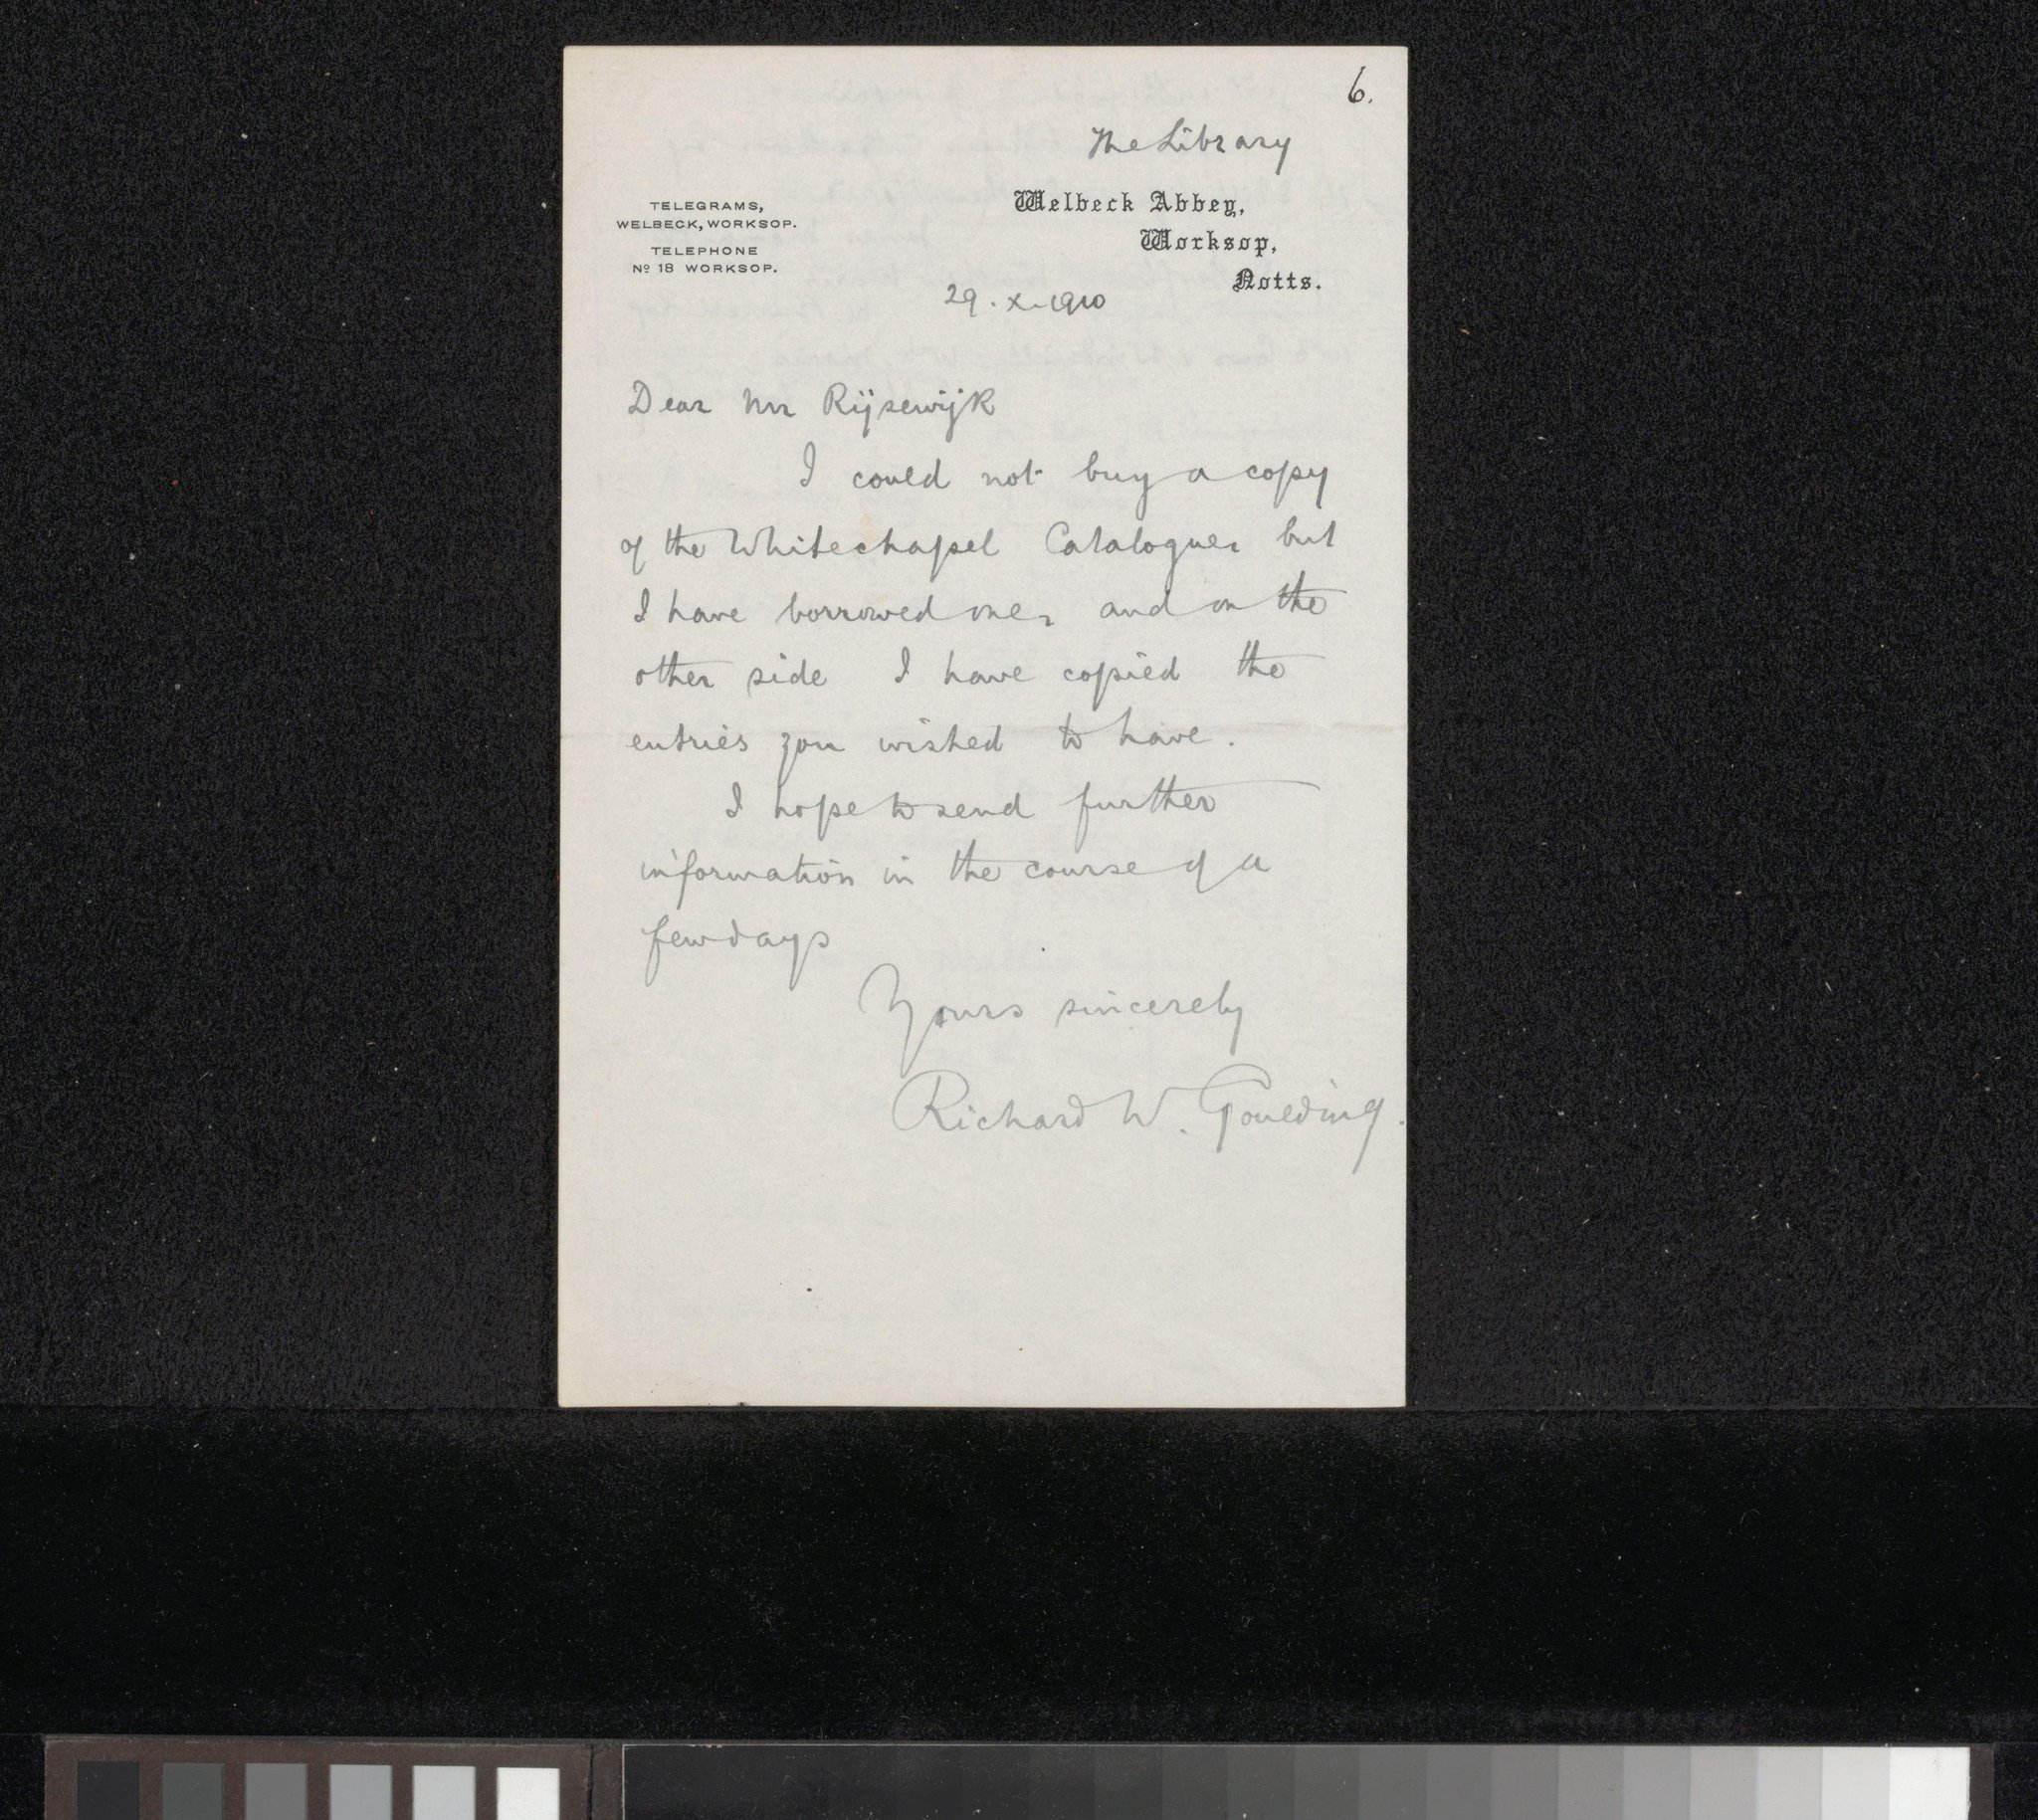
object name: letter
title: Brief aan Pieter Haverkorn van Rijsewijk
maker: richard w. goulding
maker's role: antiquair, botanicus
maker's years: 1868-1929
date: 1910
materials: ink, paper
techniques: pen, printing, writing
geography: worksop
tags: london, matthijs maris, the hague, painter, draughtsman, willem maris, jacob maris, pieter haverkorn van rijsewijk, exhibition ~ art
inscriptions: watermark